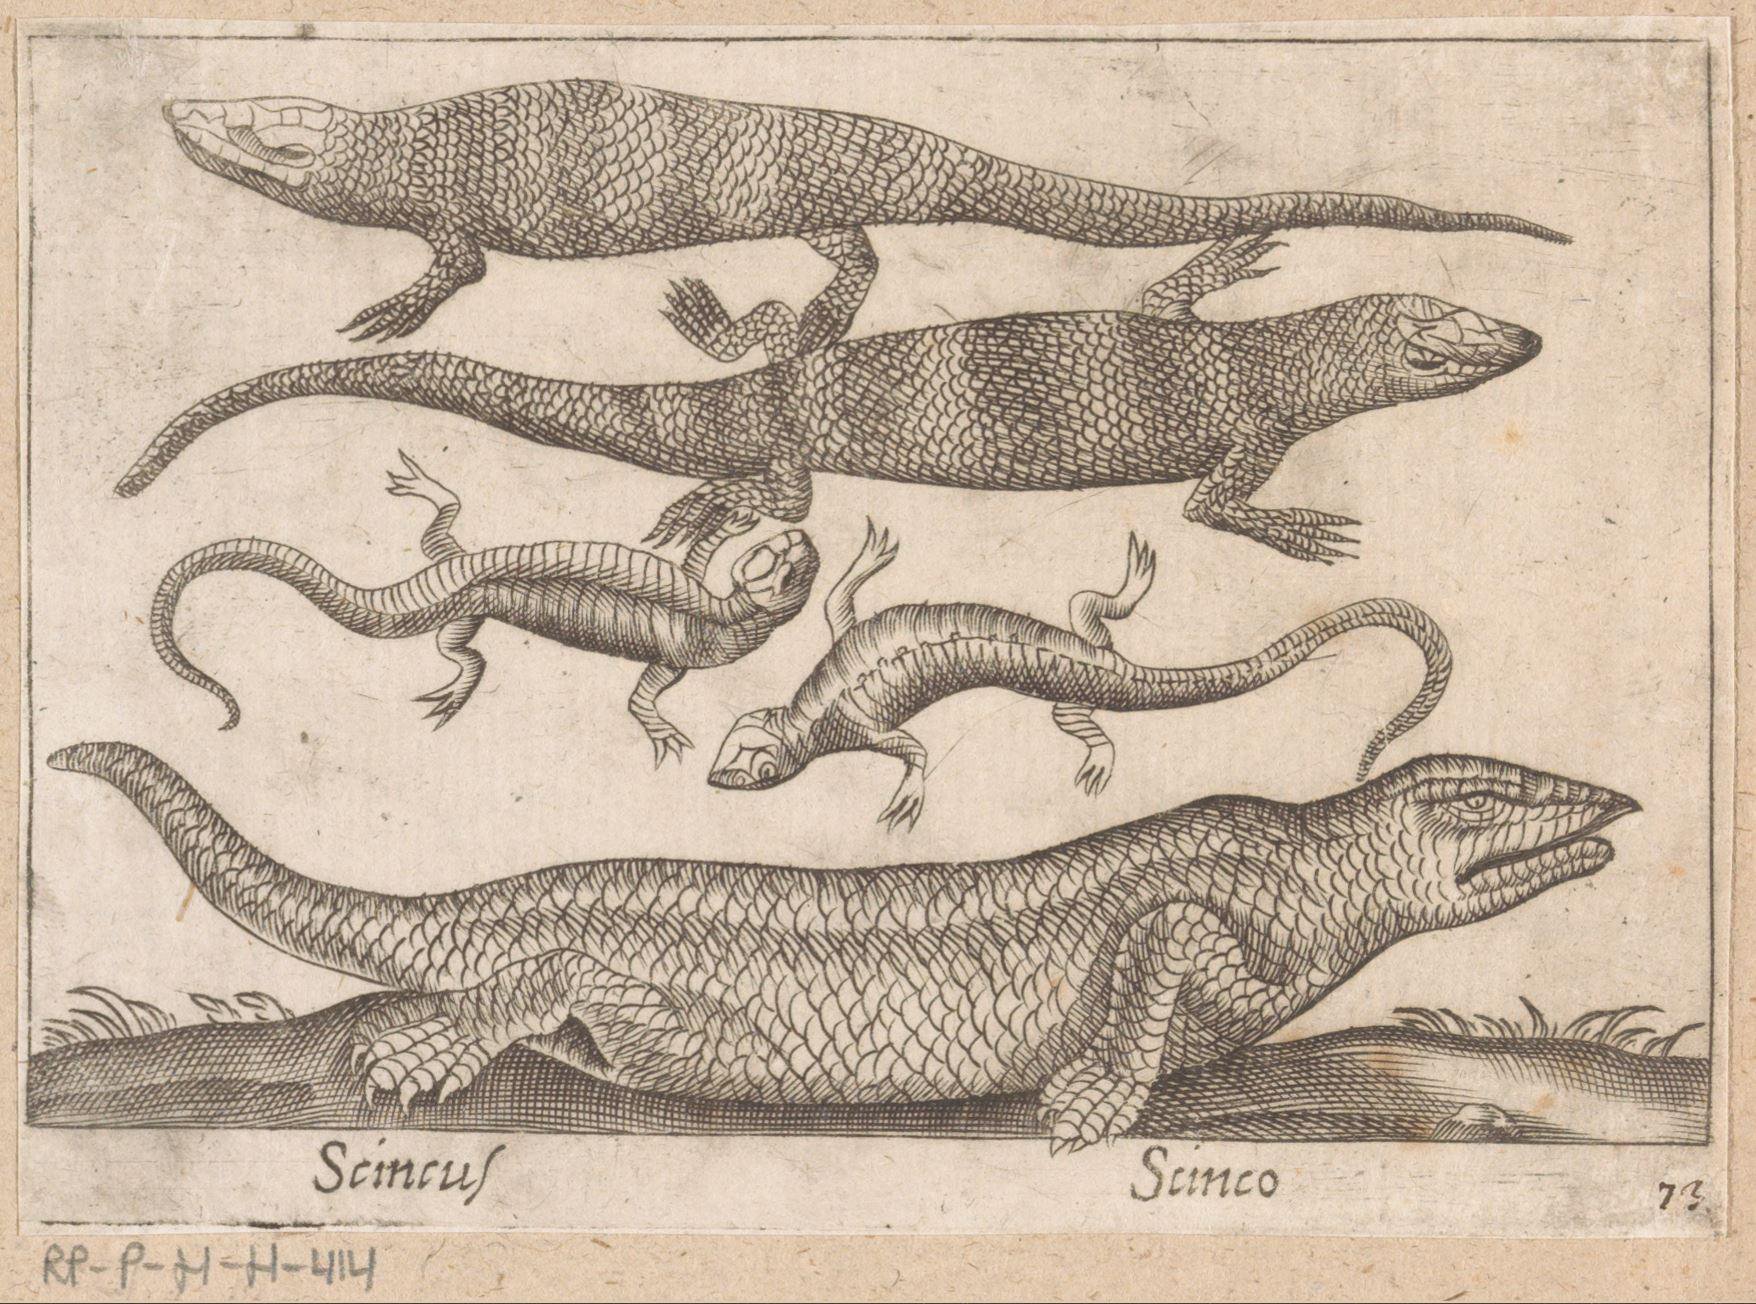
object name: print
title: Nova raccolta de li animali piu curiosi del mondo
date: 1565-1630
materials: paper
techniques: etching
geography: vatican city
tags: lizards, lizards: lizard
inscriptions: number: ‘73’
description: Deze prent maakt deel uit van een reeks prenten van dieren door Antonio Tempesta. Bekend is dat een tweede staat (met nummering) van deze serie is uitgegeven door Giovanni Giacomo de' Rossi in 1650. Onbekend is wie de eerste staat heeft uitgegeven en wanneer.